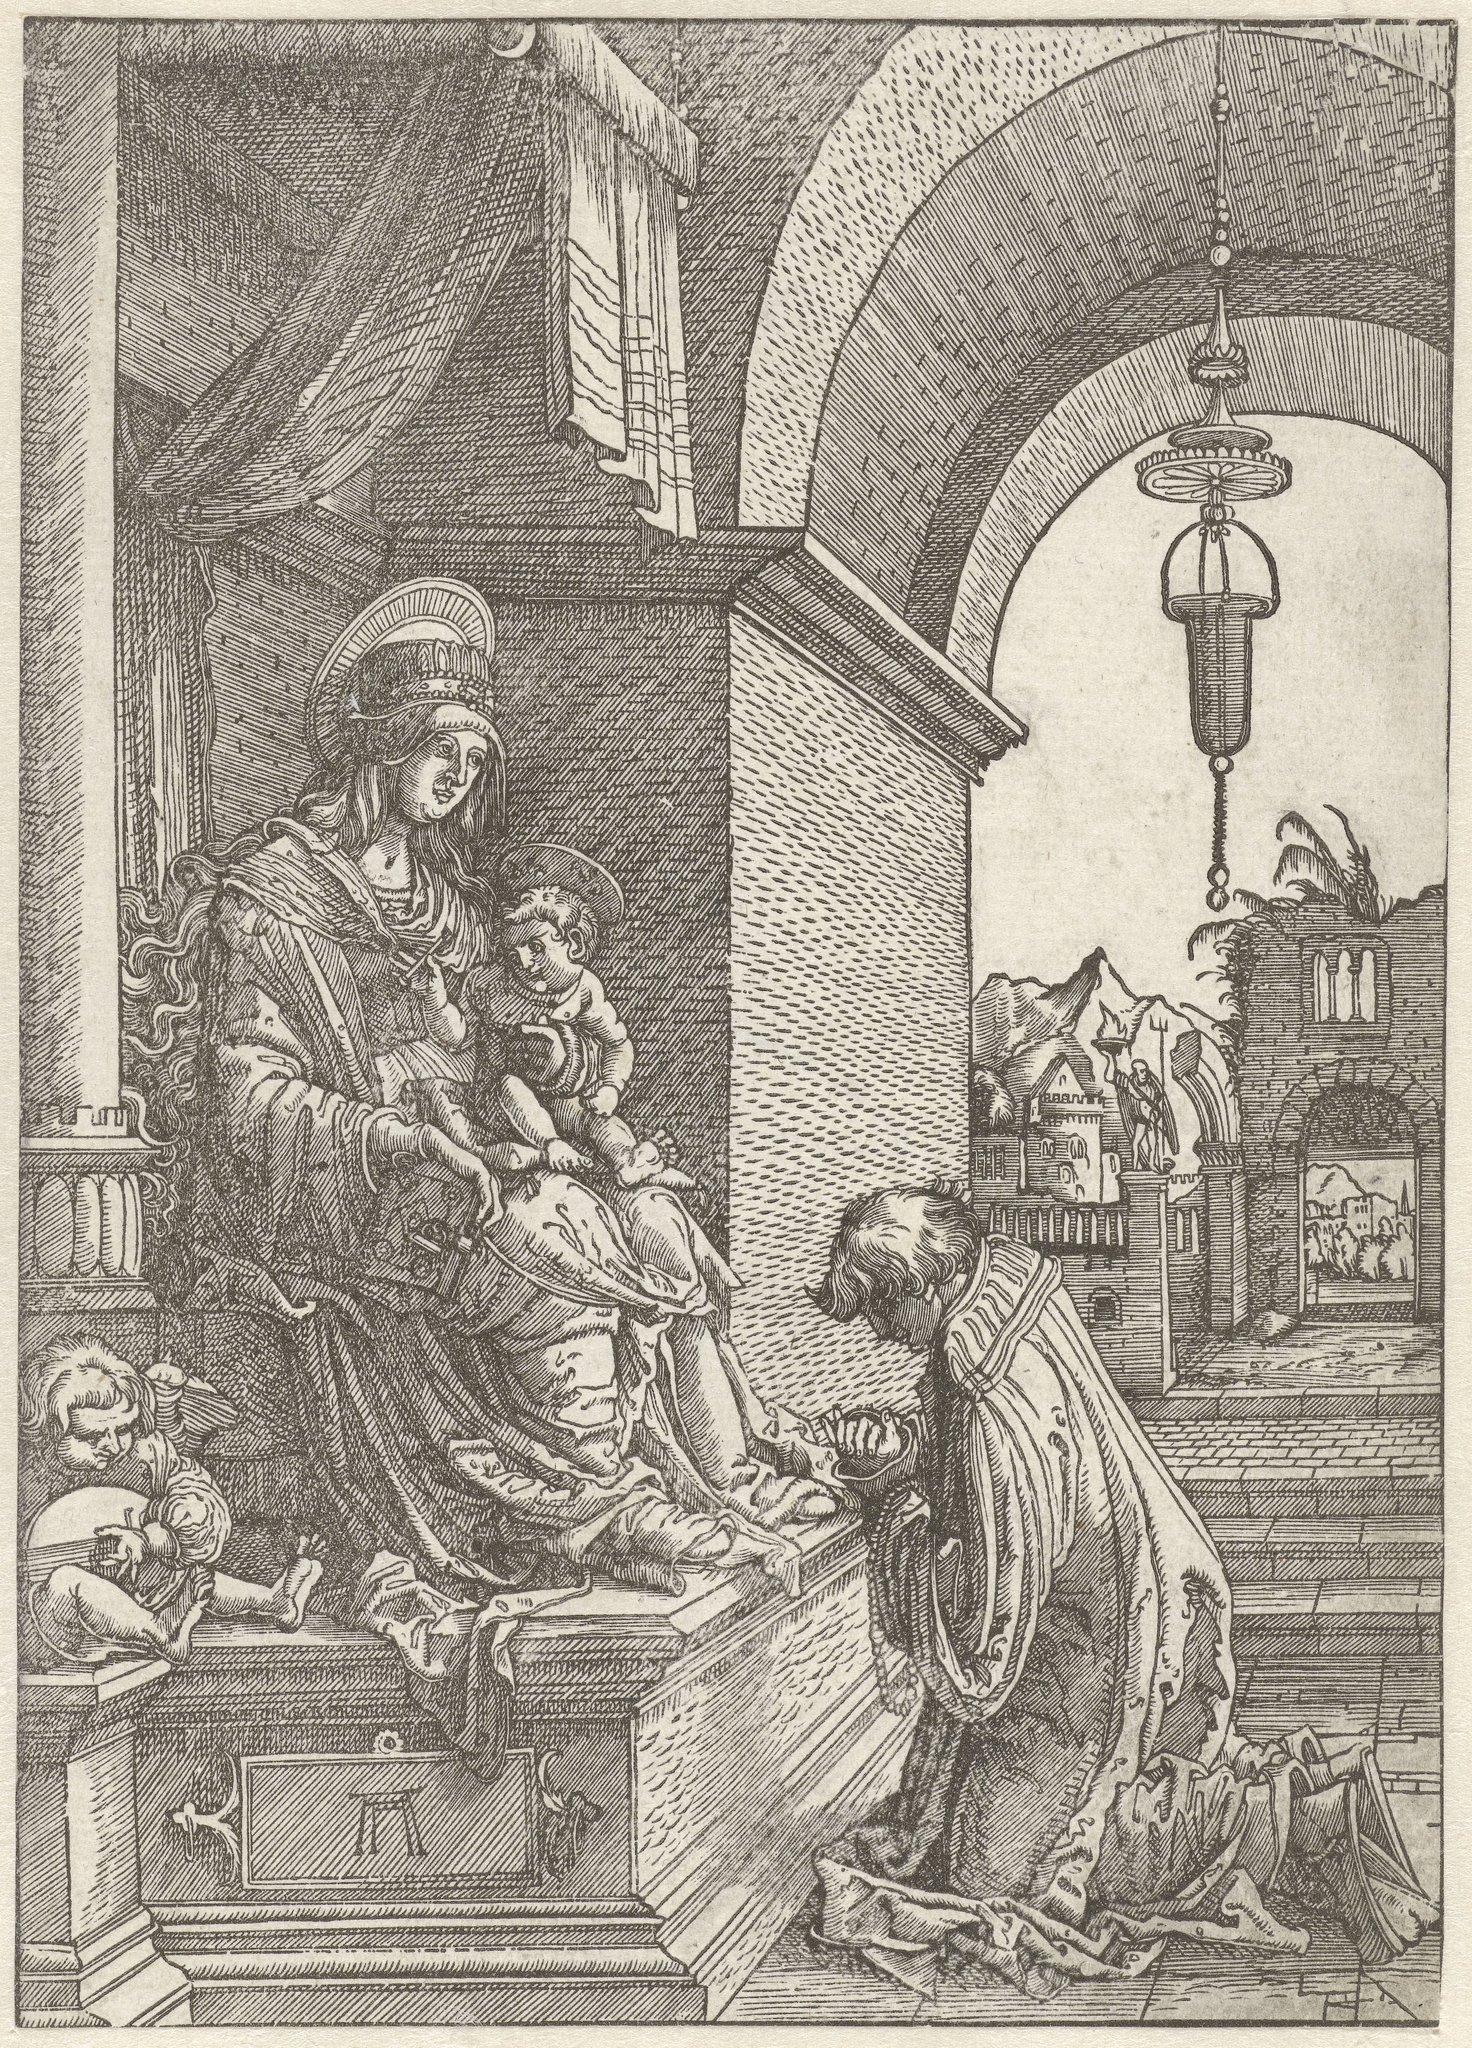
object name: print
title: Biddende geestelijke voor Maria met kind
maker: albrecht altdorfer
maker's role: draughtsman, print maker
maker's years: 1480-1538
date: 1506-1538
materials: paper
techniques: woodcut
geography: germany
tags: mary sitting or enthroned, the christ-child in front of her, sitting in her lap (or in front of her bosom) (+ donor(s), supplicant(s), whether or not with patron saint(s))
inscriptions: number: ‘68’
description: Maria met het Christuskind op schoot, zittend op een piëdestal. Voor haar knielt een geestelijke, hij heeft zijn handen gevouden en het hoofd gebogen.